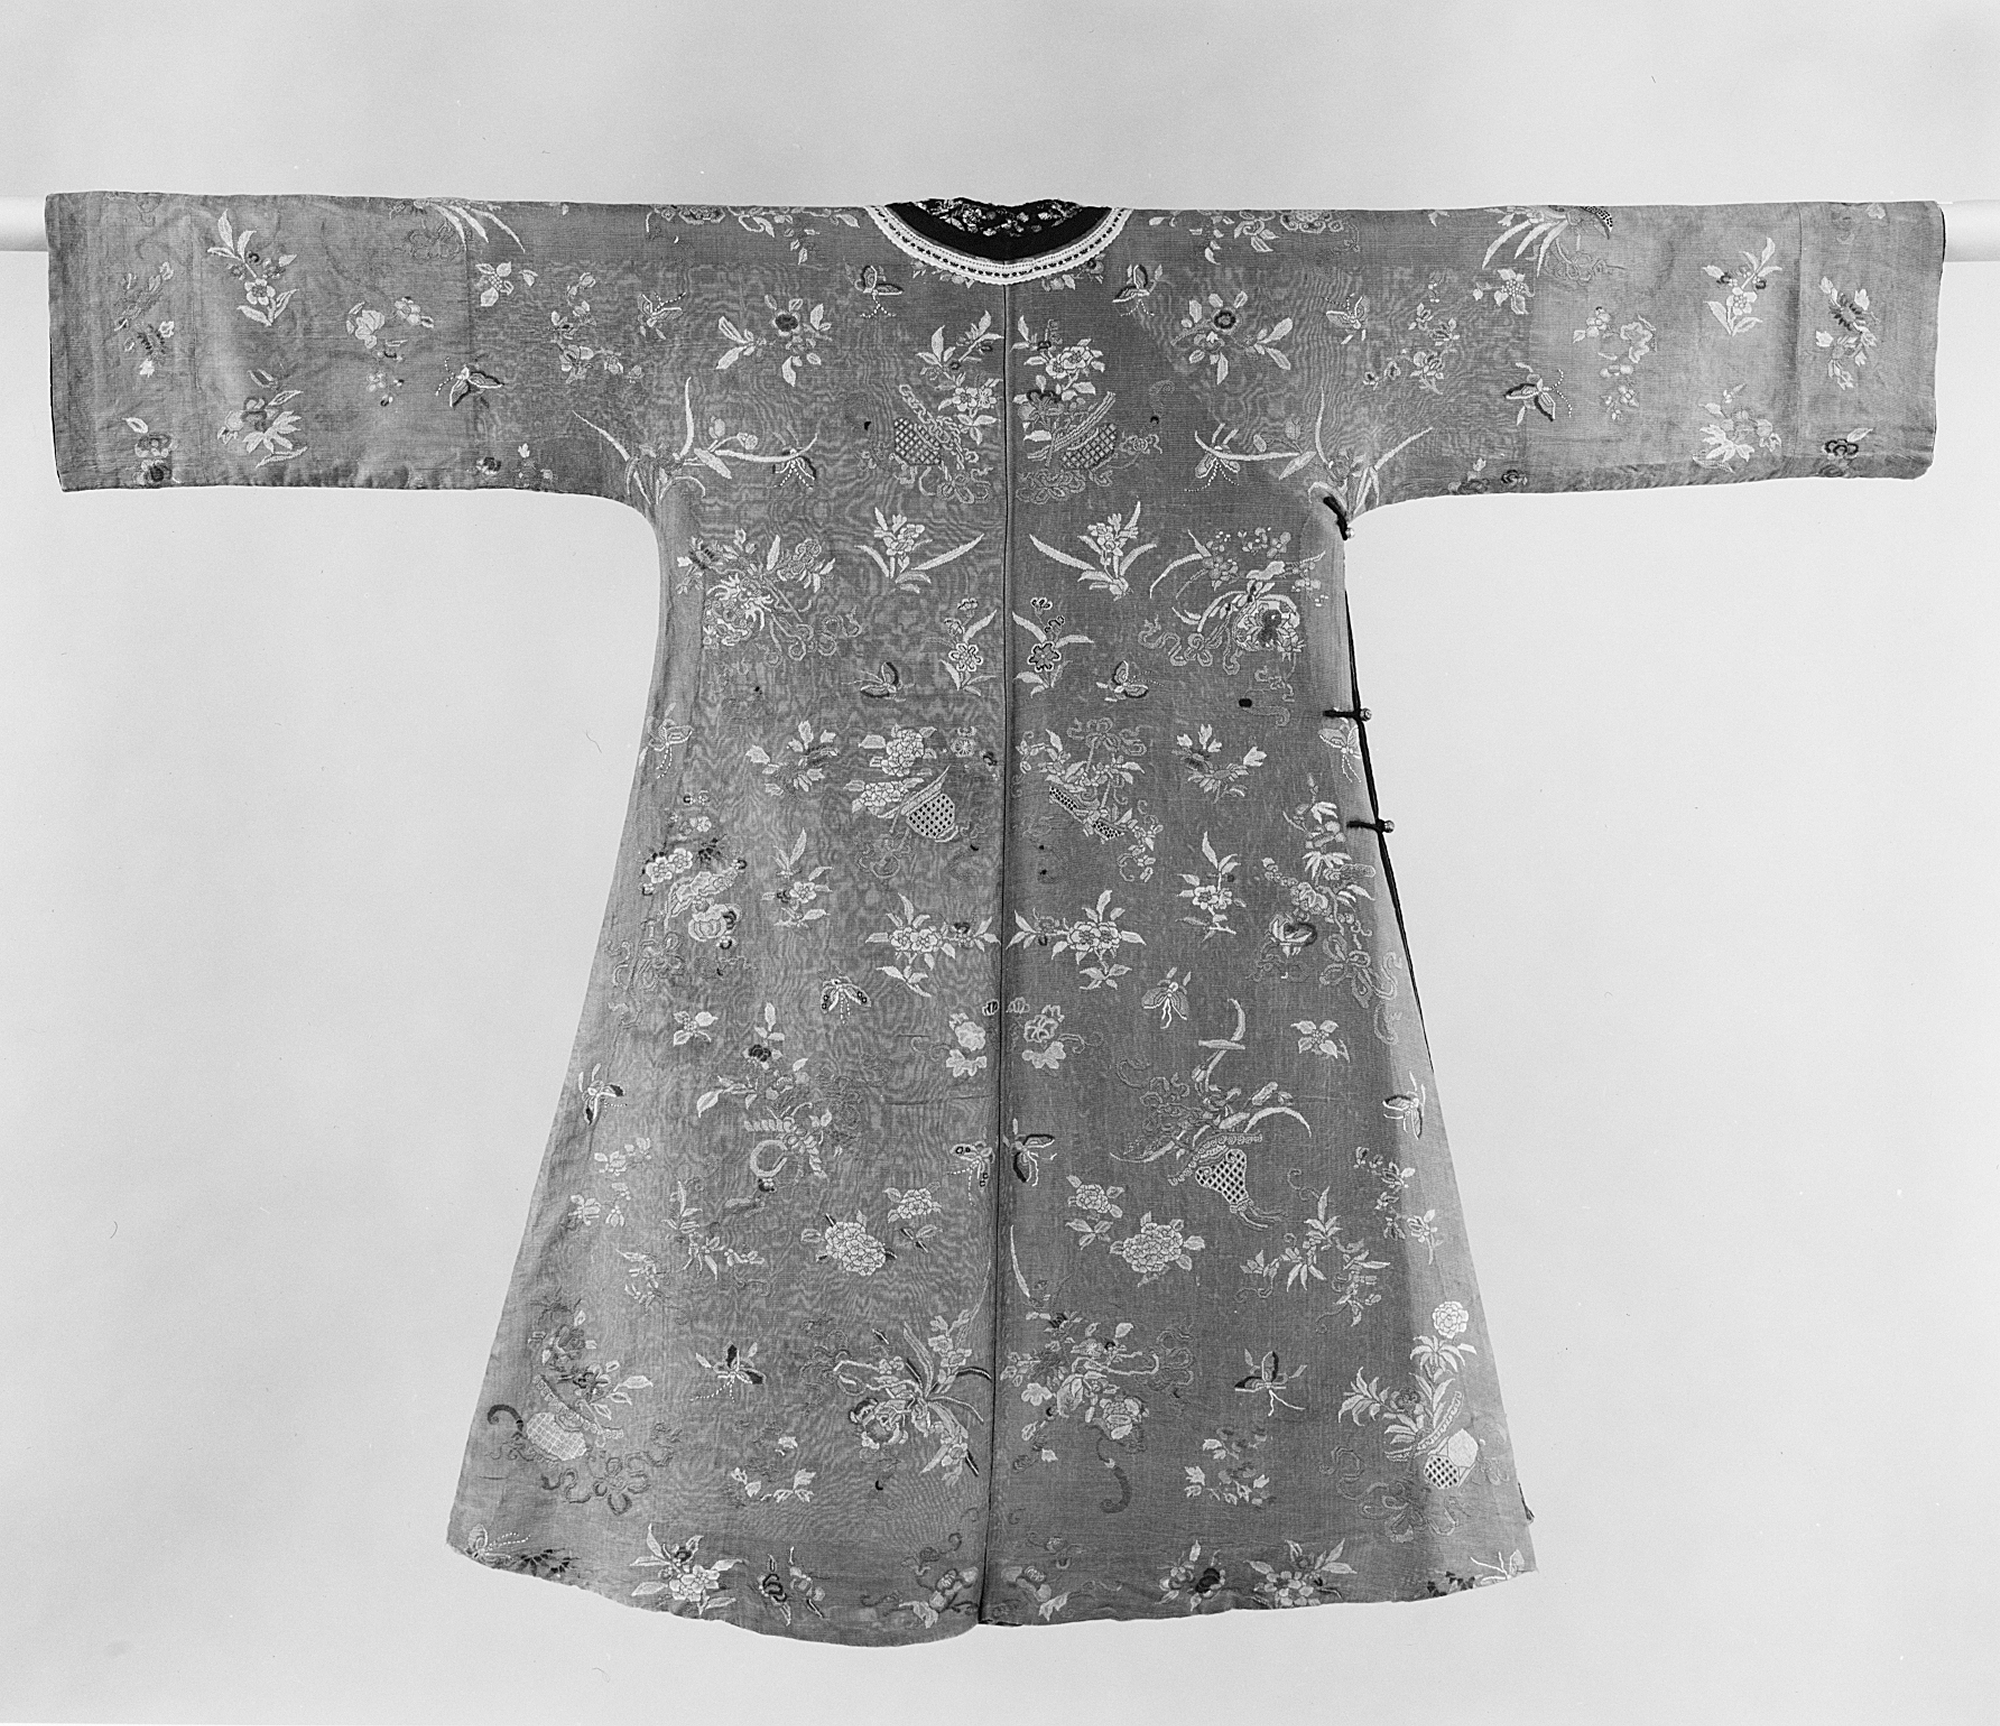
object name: woman's informal robe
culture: chinese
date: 1644-1911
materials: silk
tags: butterflies,flowers